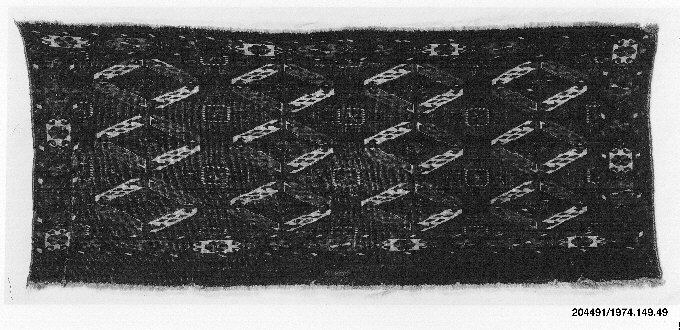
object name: storage bag fragment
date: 1834-1866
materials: wool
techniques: asymmetrically knotted pile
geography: turkmenistan